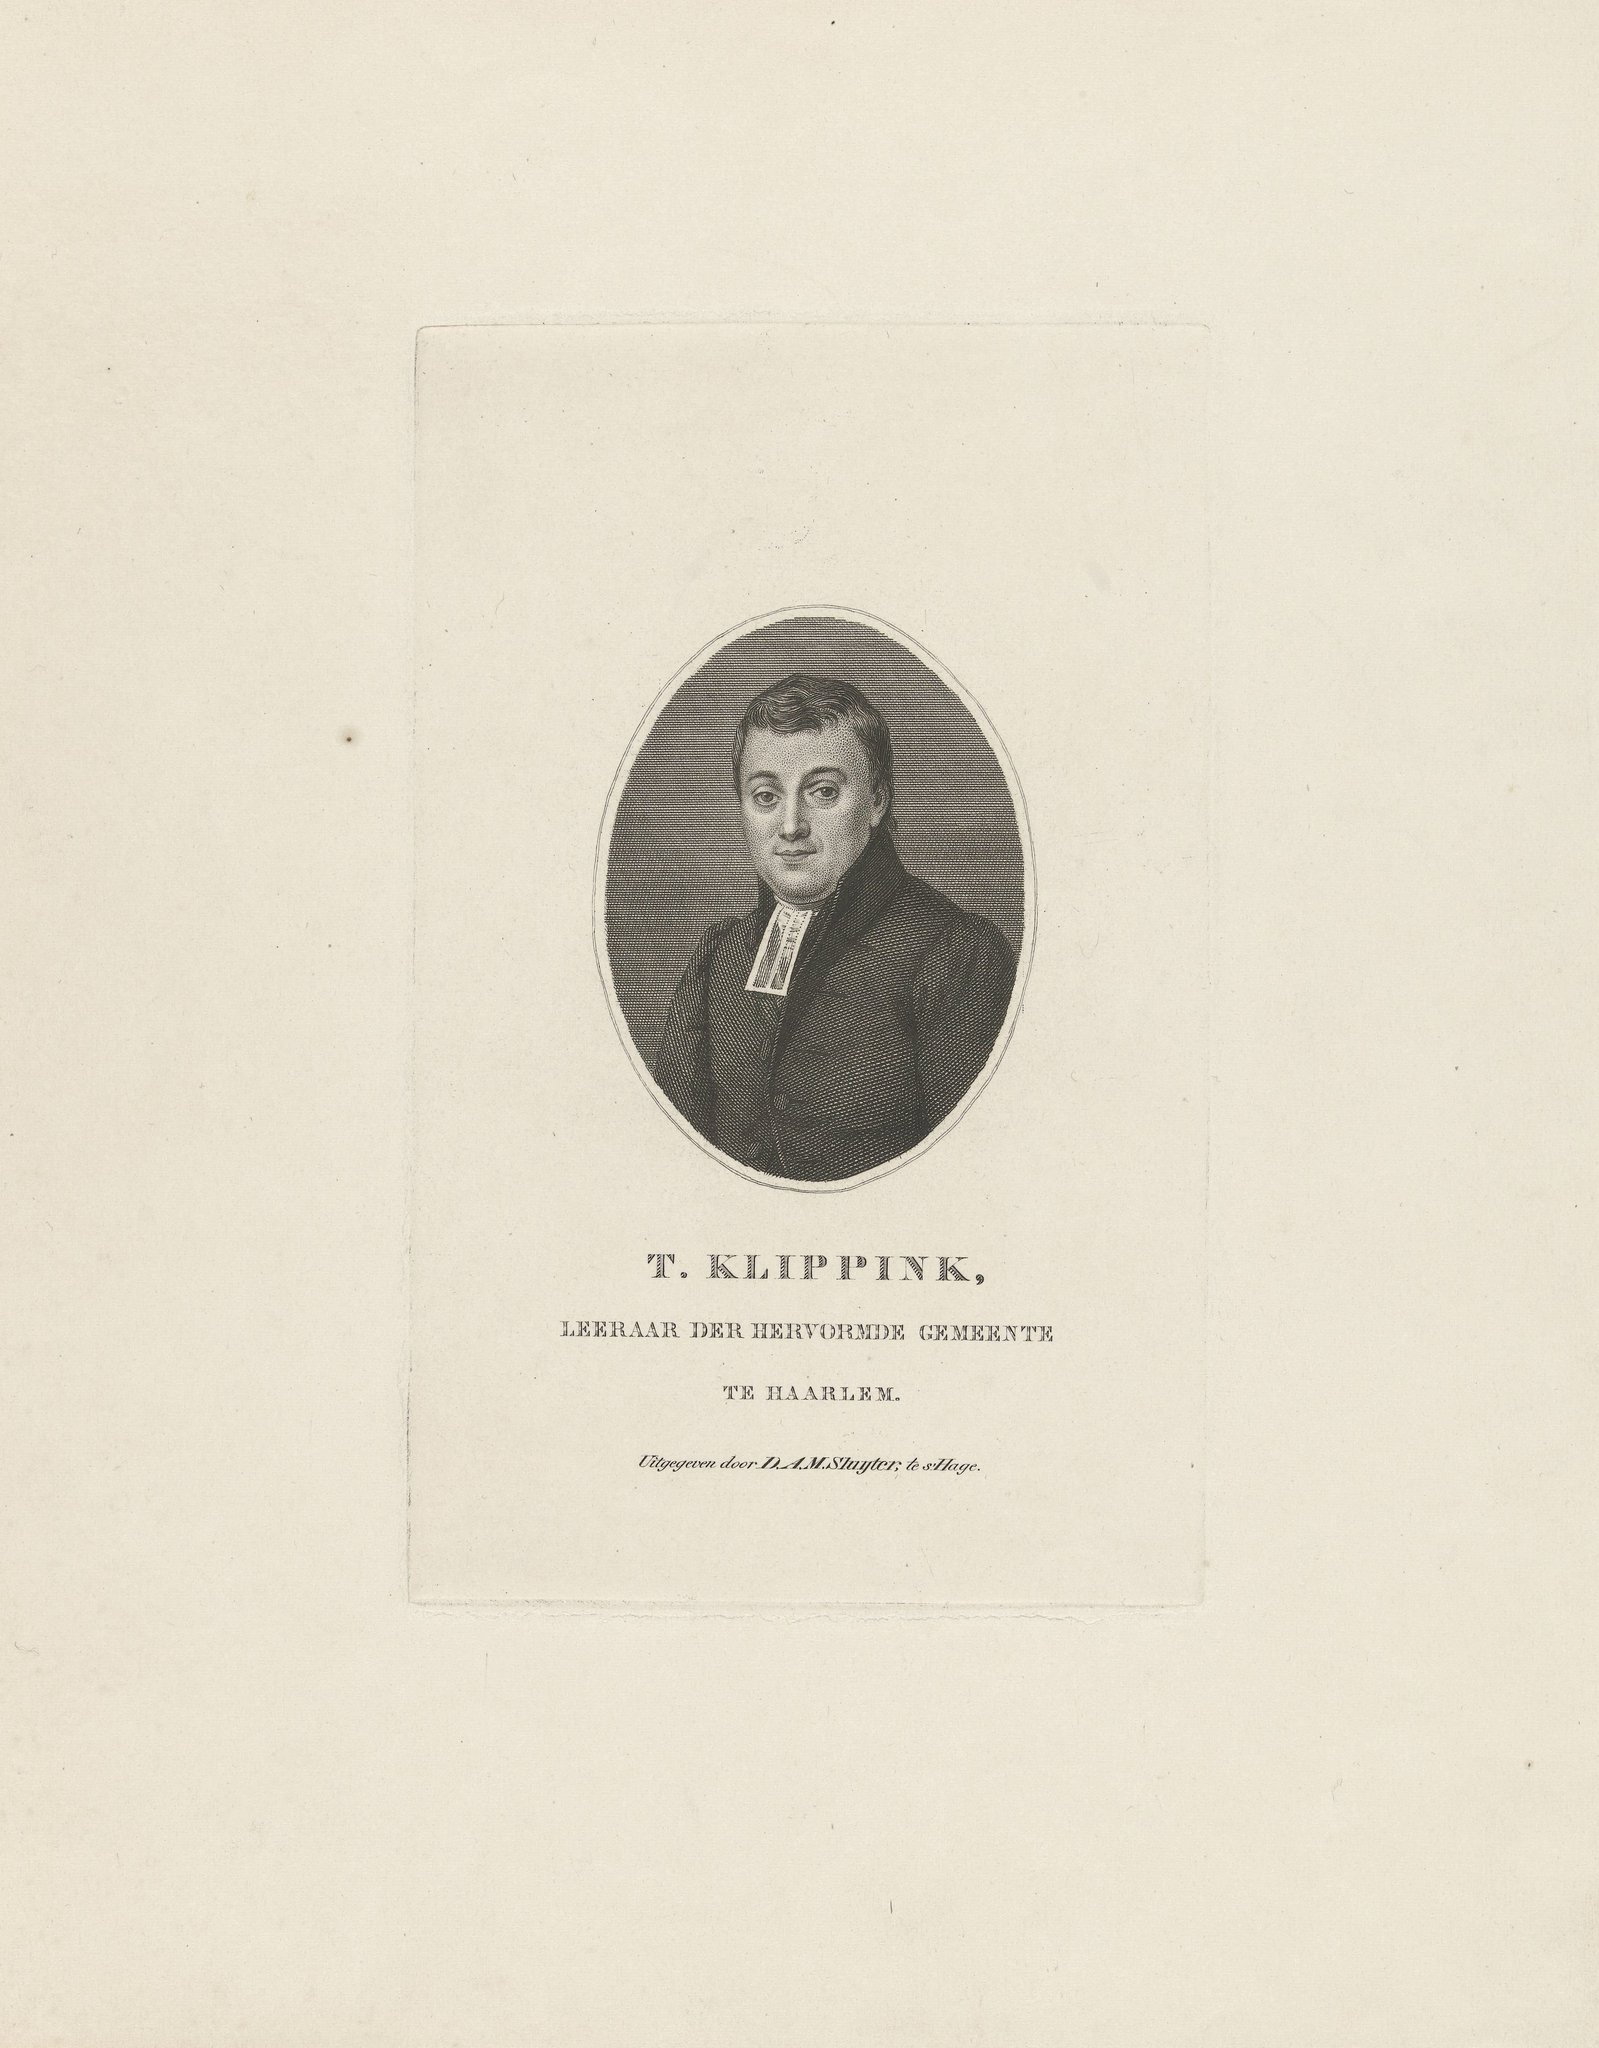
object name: print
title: Portret van Thomas Klippink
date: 1827-1837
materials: paper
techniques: engraving, etching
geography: the hague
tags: predikant, thomas klippink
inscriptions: collector's mark: Lugt 2228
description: Portret van Thomas Klippink, Hervormd predikant te Haarlem, gekleed in een zwarte jas met een witte bef. Buste naar links in ovaal. Onderaan in de marge een tweeregelige tekst in het Nederlands.